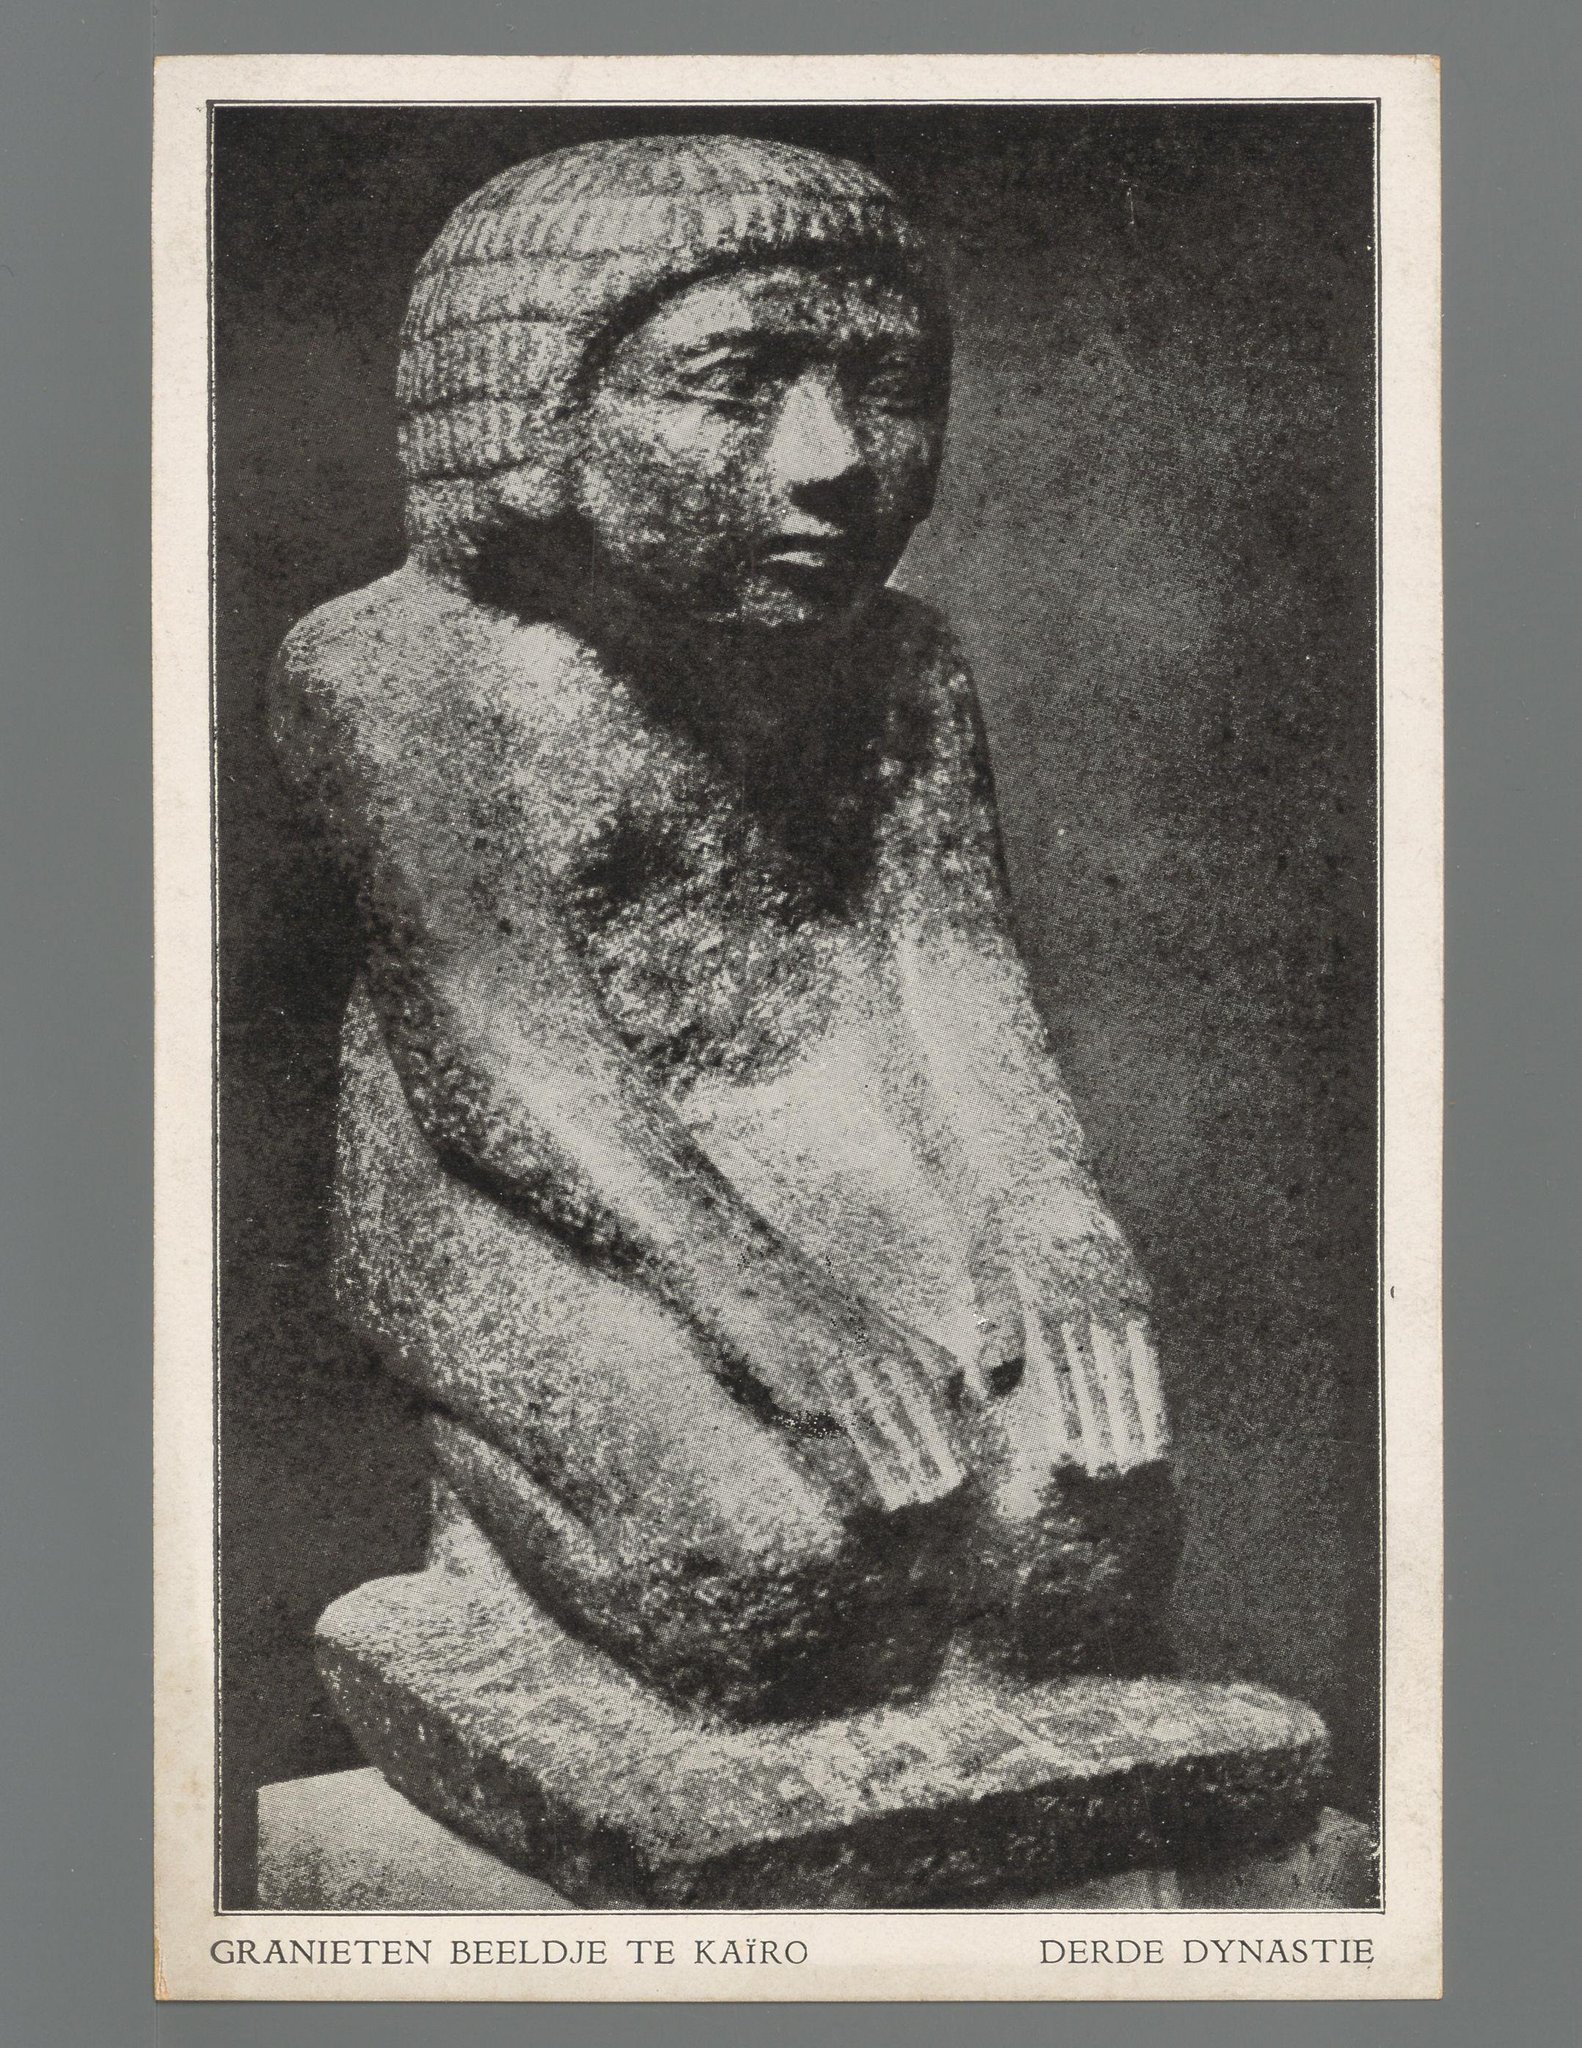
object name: photomechanical print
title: Granieten beeldje te Kaïro. Derde dynastie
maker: Anonymous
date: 1925-1935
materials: cardboard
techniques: autotype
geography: amsterdam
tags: sculpture, kneeling figure